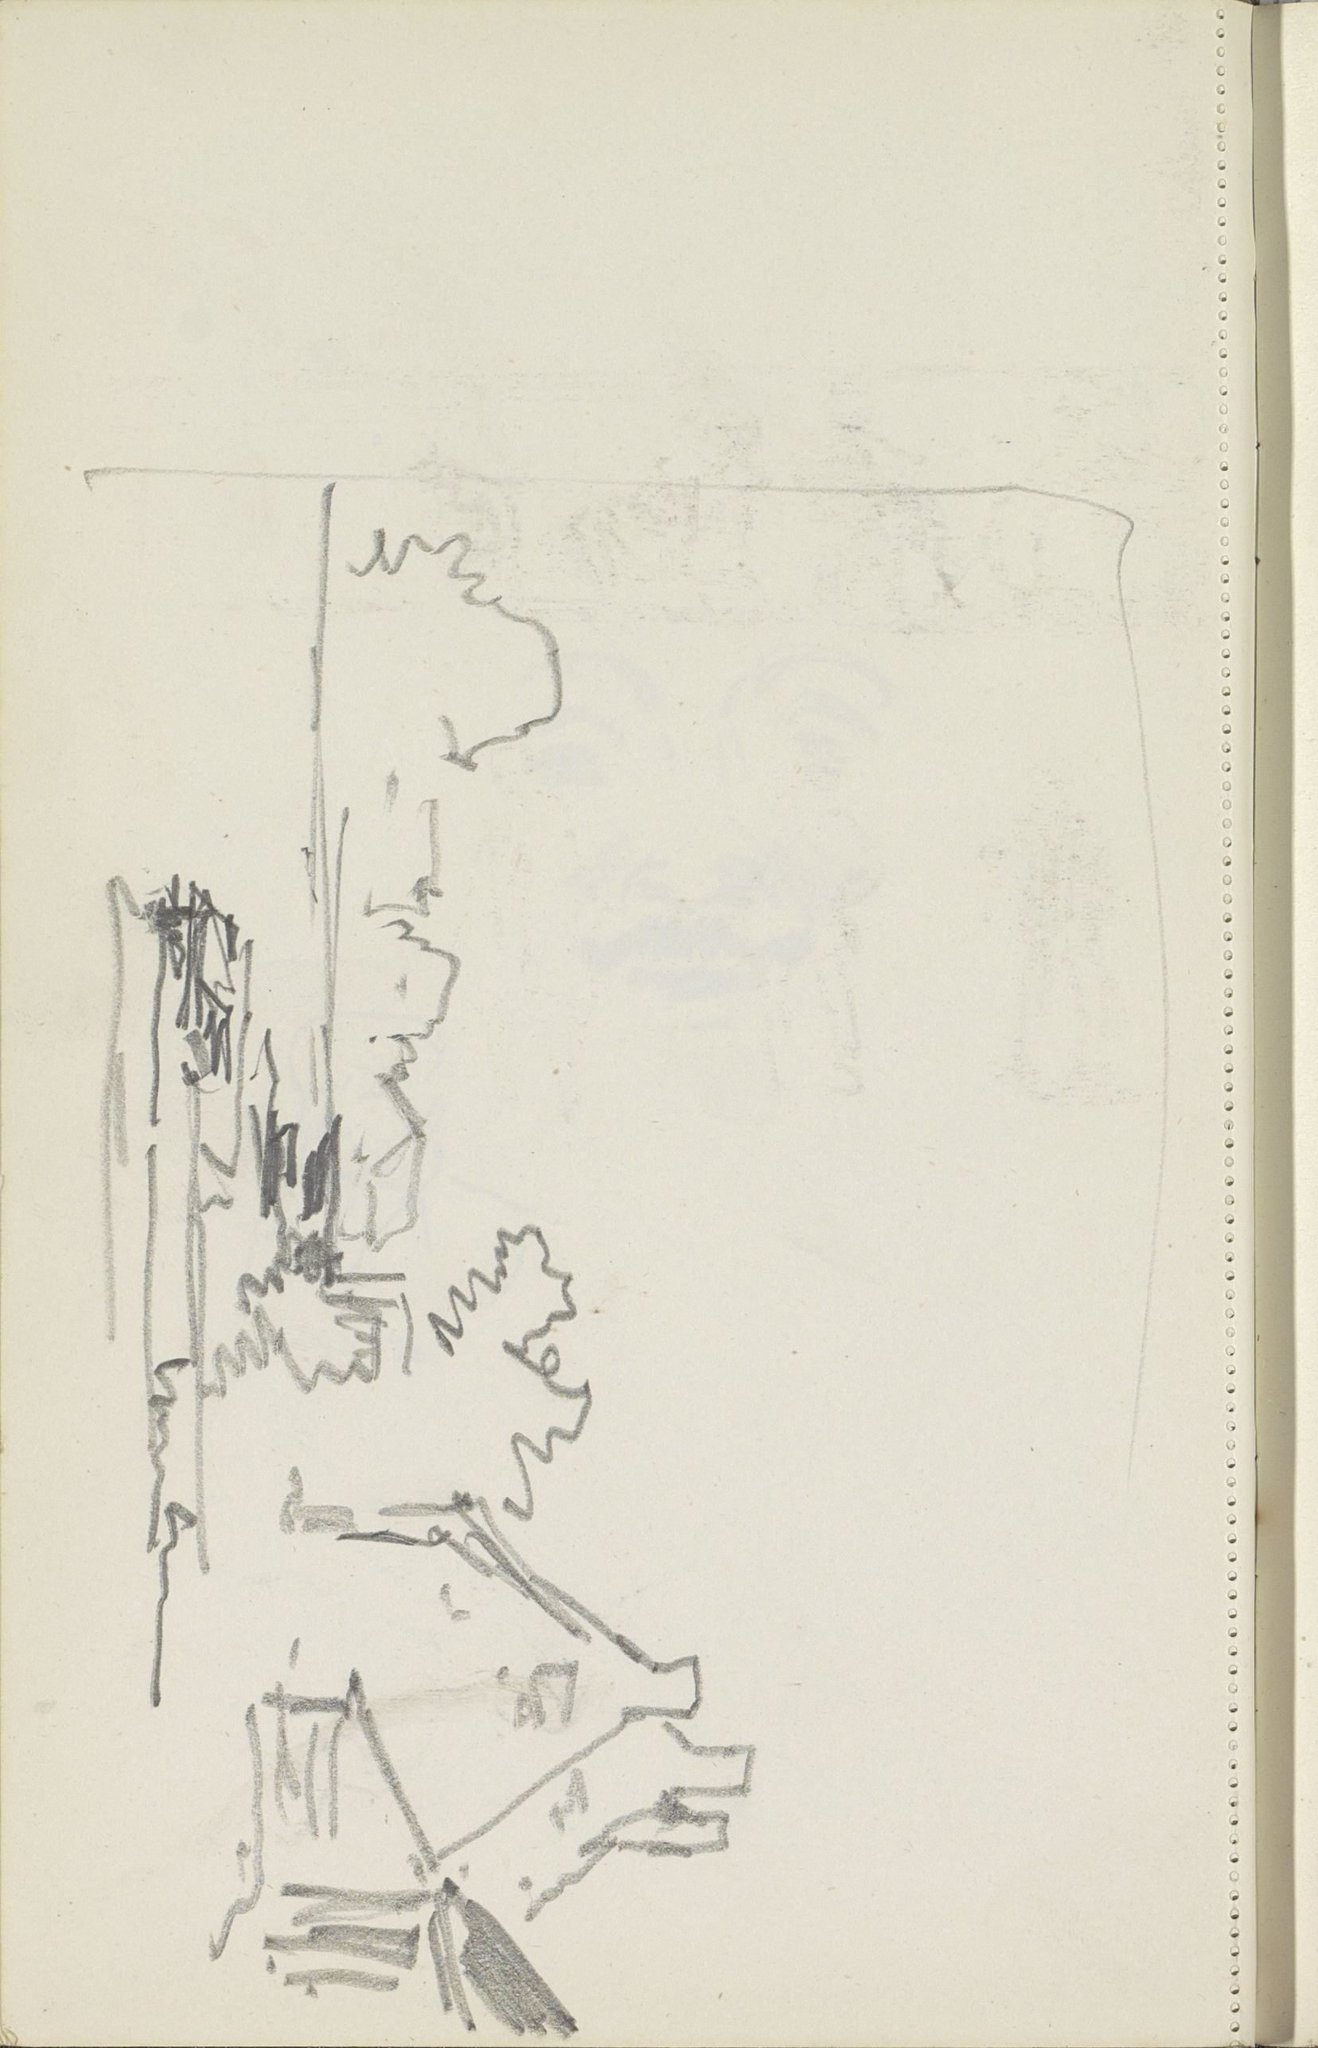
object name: sketchbook leaf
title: Landschap met huizen aan een waterkant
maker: cornelis vreedenburgh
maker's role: draughtsman, print maker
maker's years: 1880-1946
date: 1890-1946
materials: paper, pencil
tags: city-view, and landscape with man-made constructions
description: Blad 40 verso uit een schetsboek met 50 bladen.